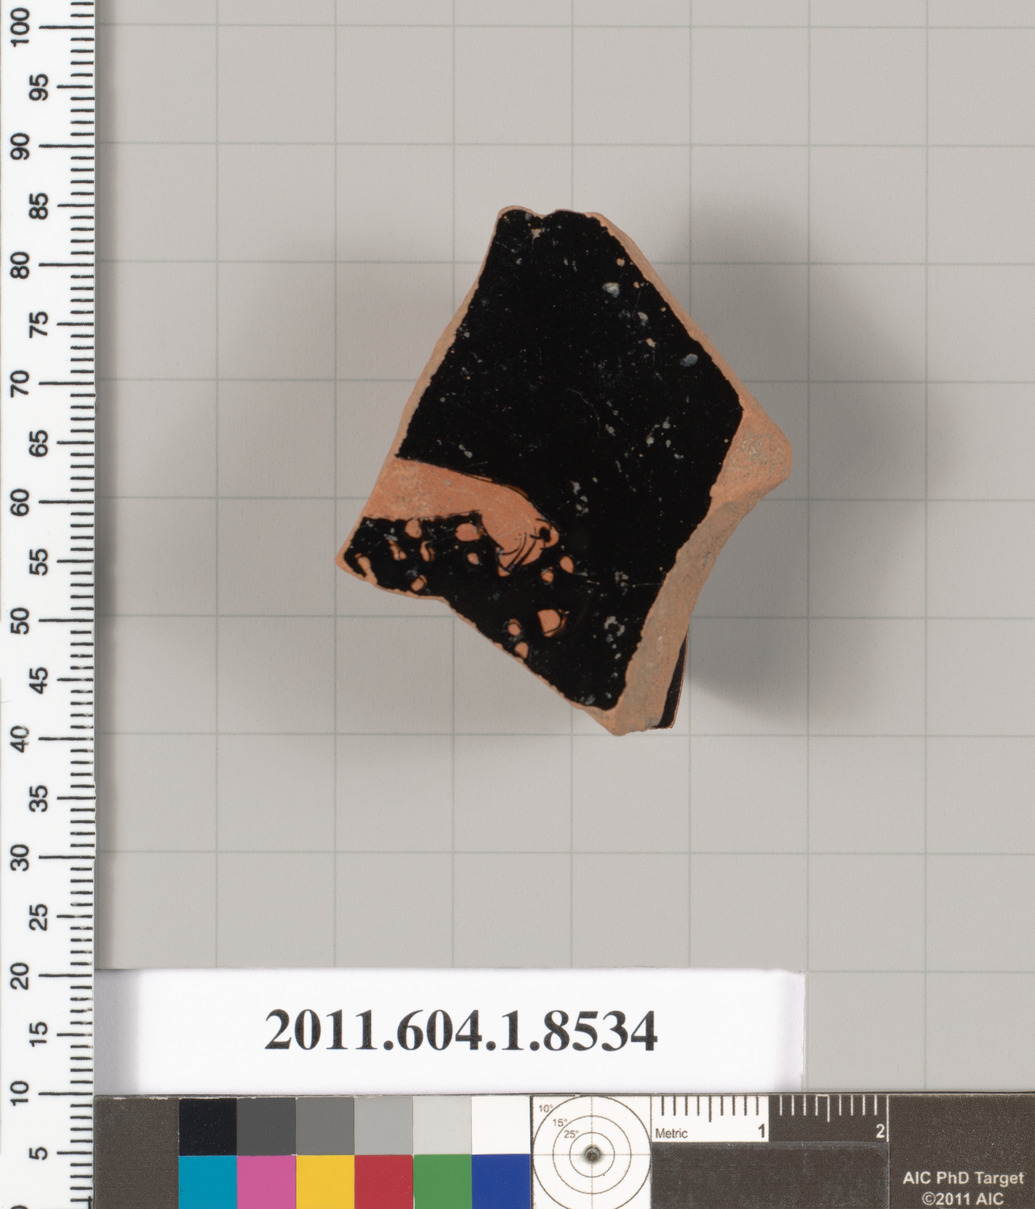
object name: kylix fragment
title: Terracotta fragment of a stemless kylix (drinking cup)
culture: greek, attic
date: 460-450 BCE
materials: terracotta